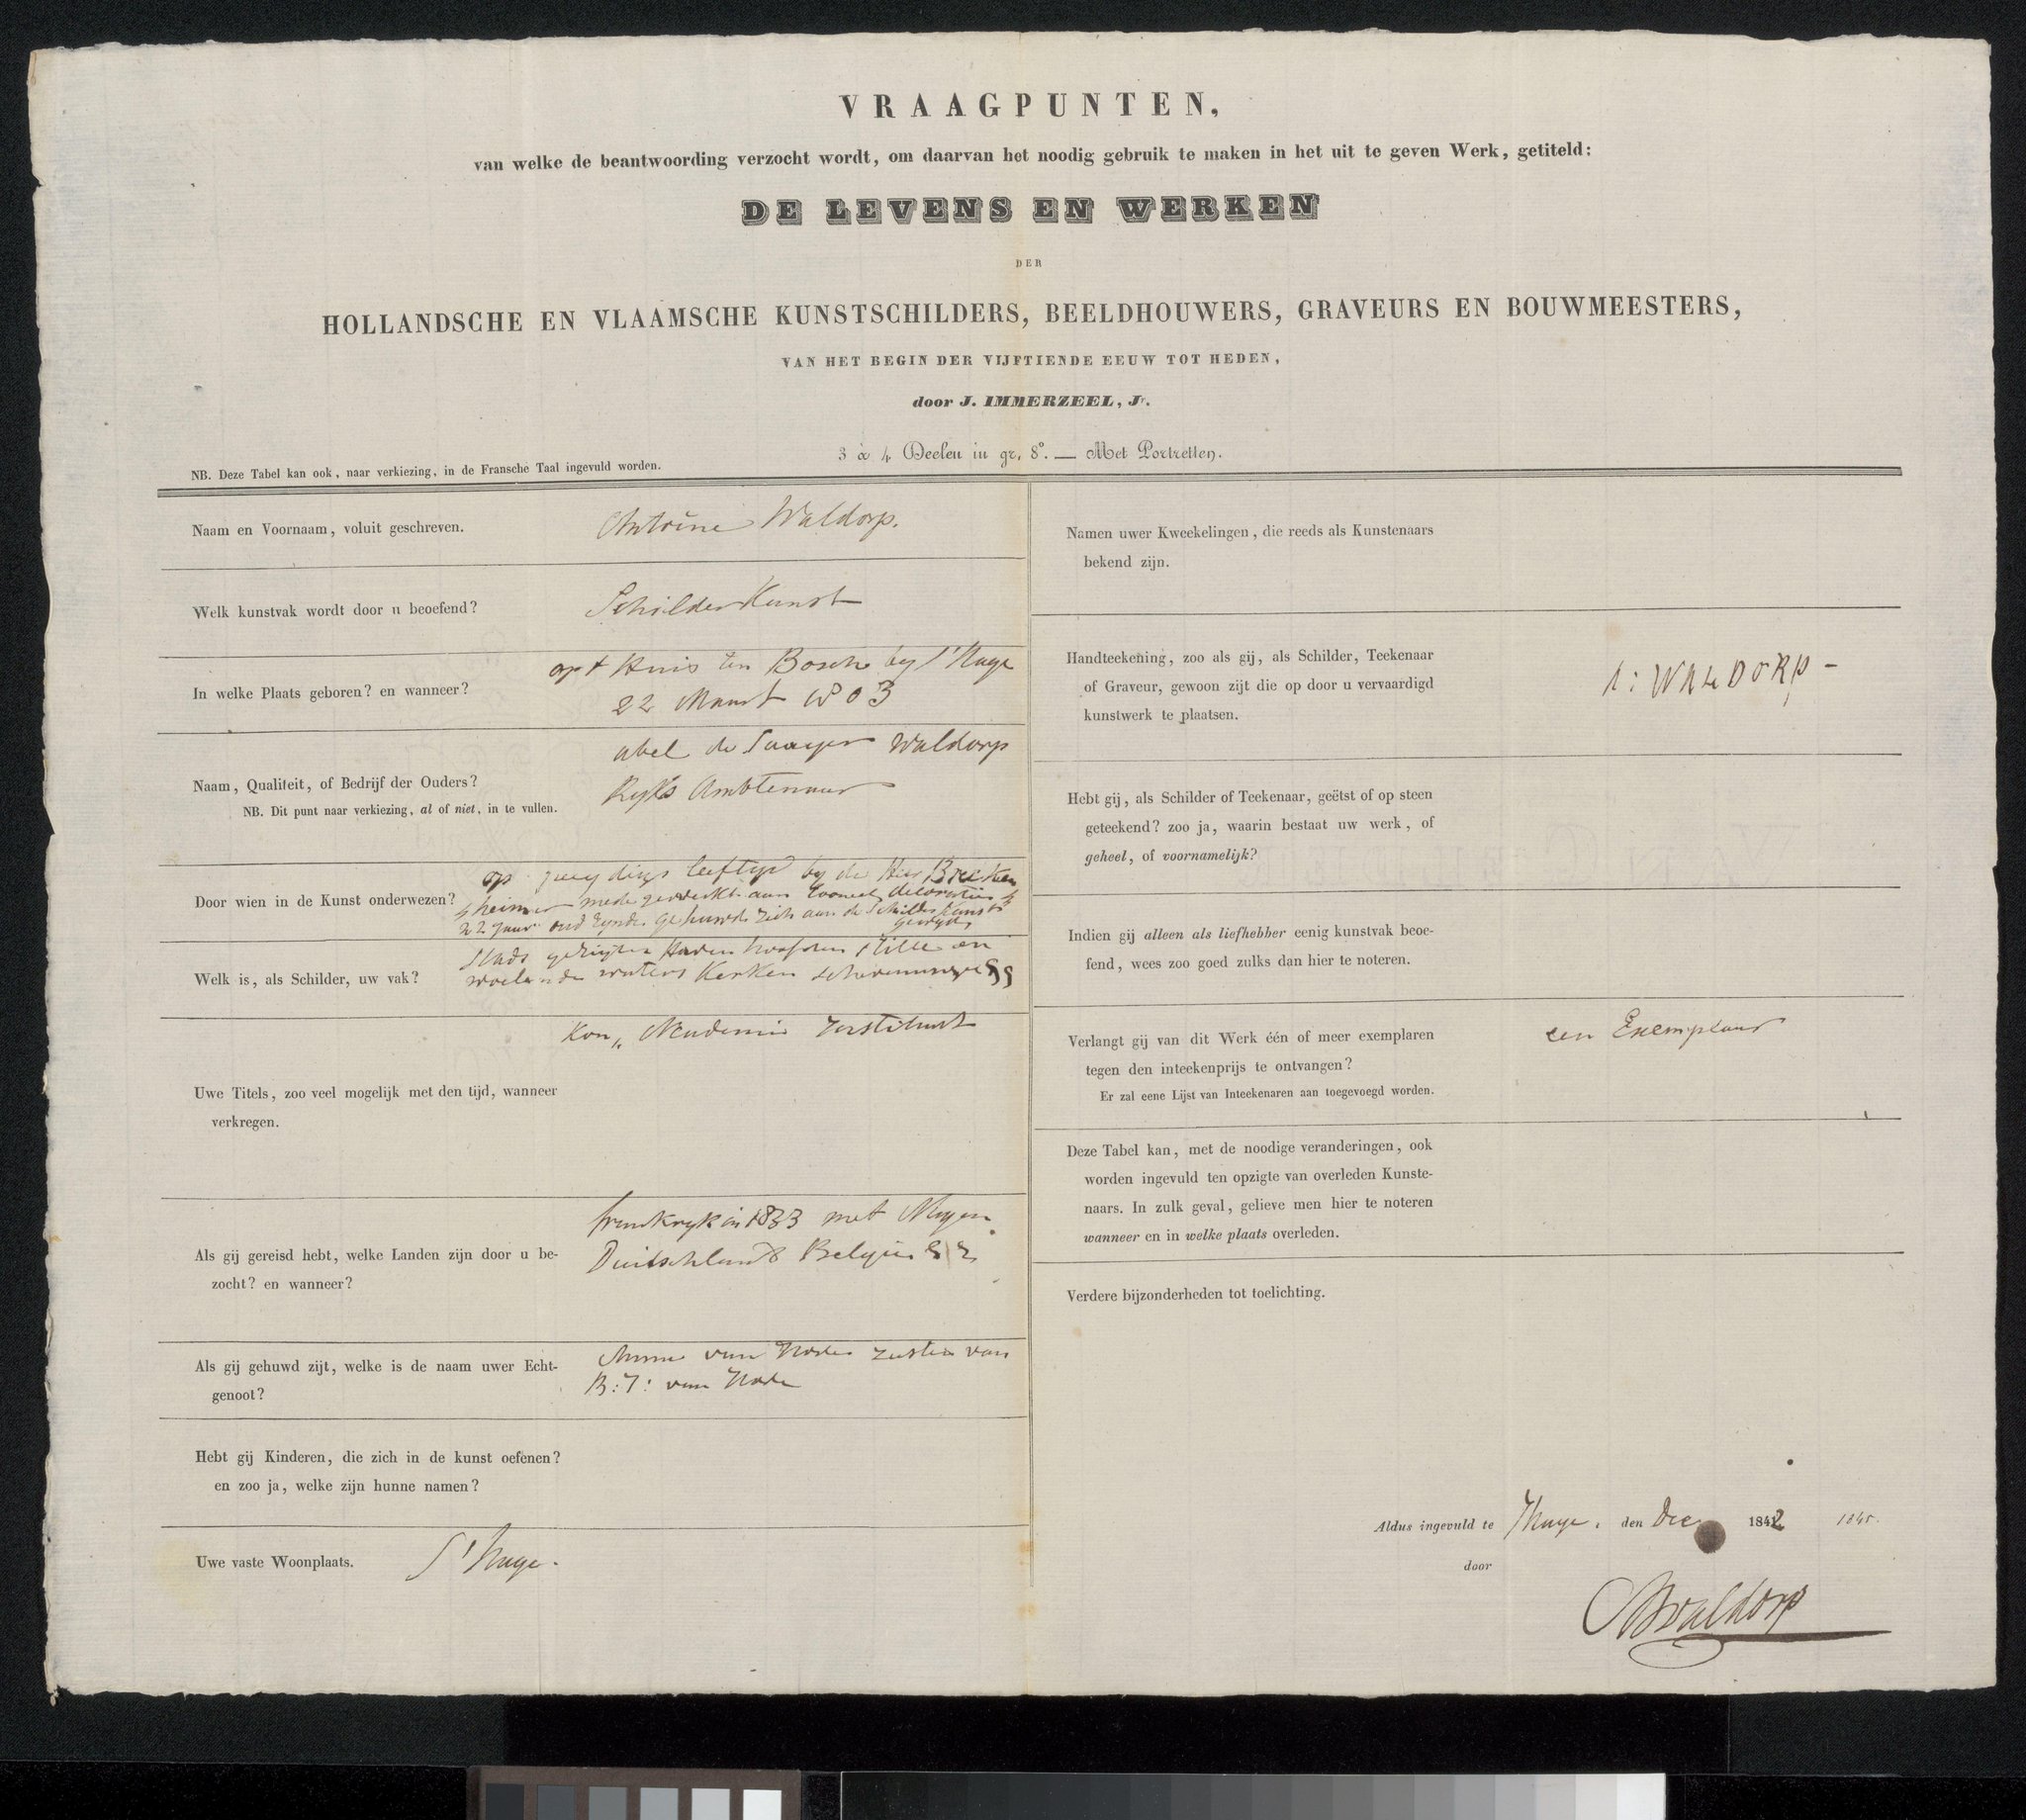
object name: manuscript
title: Enquêteformulier ingevuld door Antonie Waldorp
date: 1812-1842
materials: ink, paper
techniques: pen, printing, writing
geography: the hague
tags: draughtsman, antonie waldorp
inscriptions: inscription: ‘Vraagpunten,/ van welke de beantwoording verzocht wordt, om daarvan het noodig gebruik te maken in het uit te geven Werk, getiteld: De levens en werken/ der Hollandsche en Vlaamsche kunstschilders, beeldhouwers,/ graveurs en bouwmeesters, van het begin der vijftiende eeuw tot heden/ door J. Immerzeel, Jr.’, watermark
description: Opgenomen in: Immerzeel, J. Jr., De levens en werken der Hollandsche en Vlaamsche kunstschilders, beeldhouwers, graveurs en bouwmeesters, van het begin der vijftiende eeuw tot heden, Amsterdam: J.C. van Kesteren, 1842-1843.